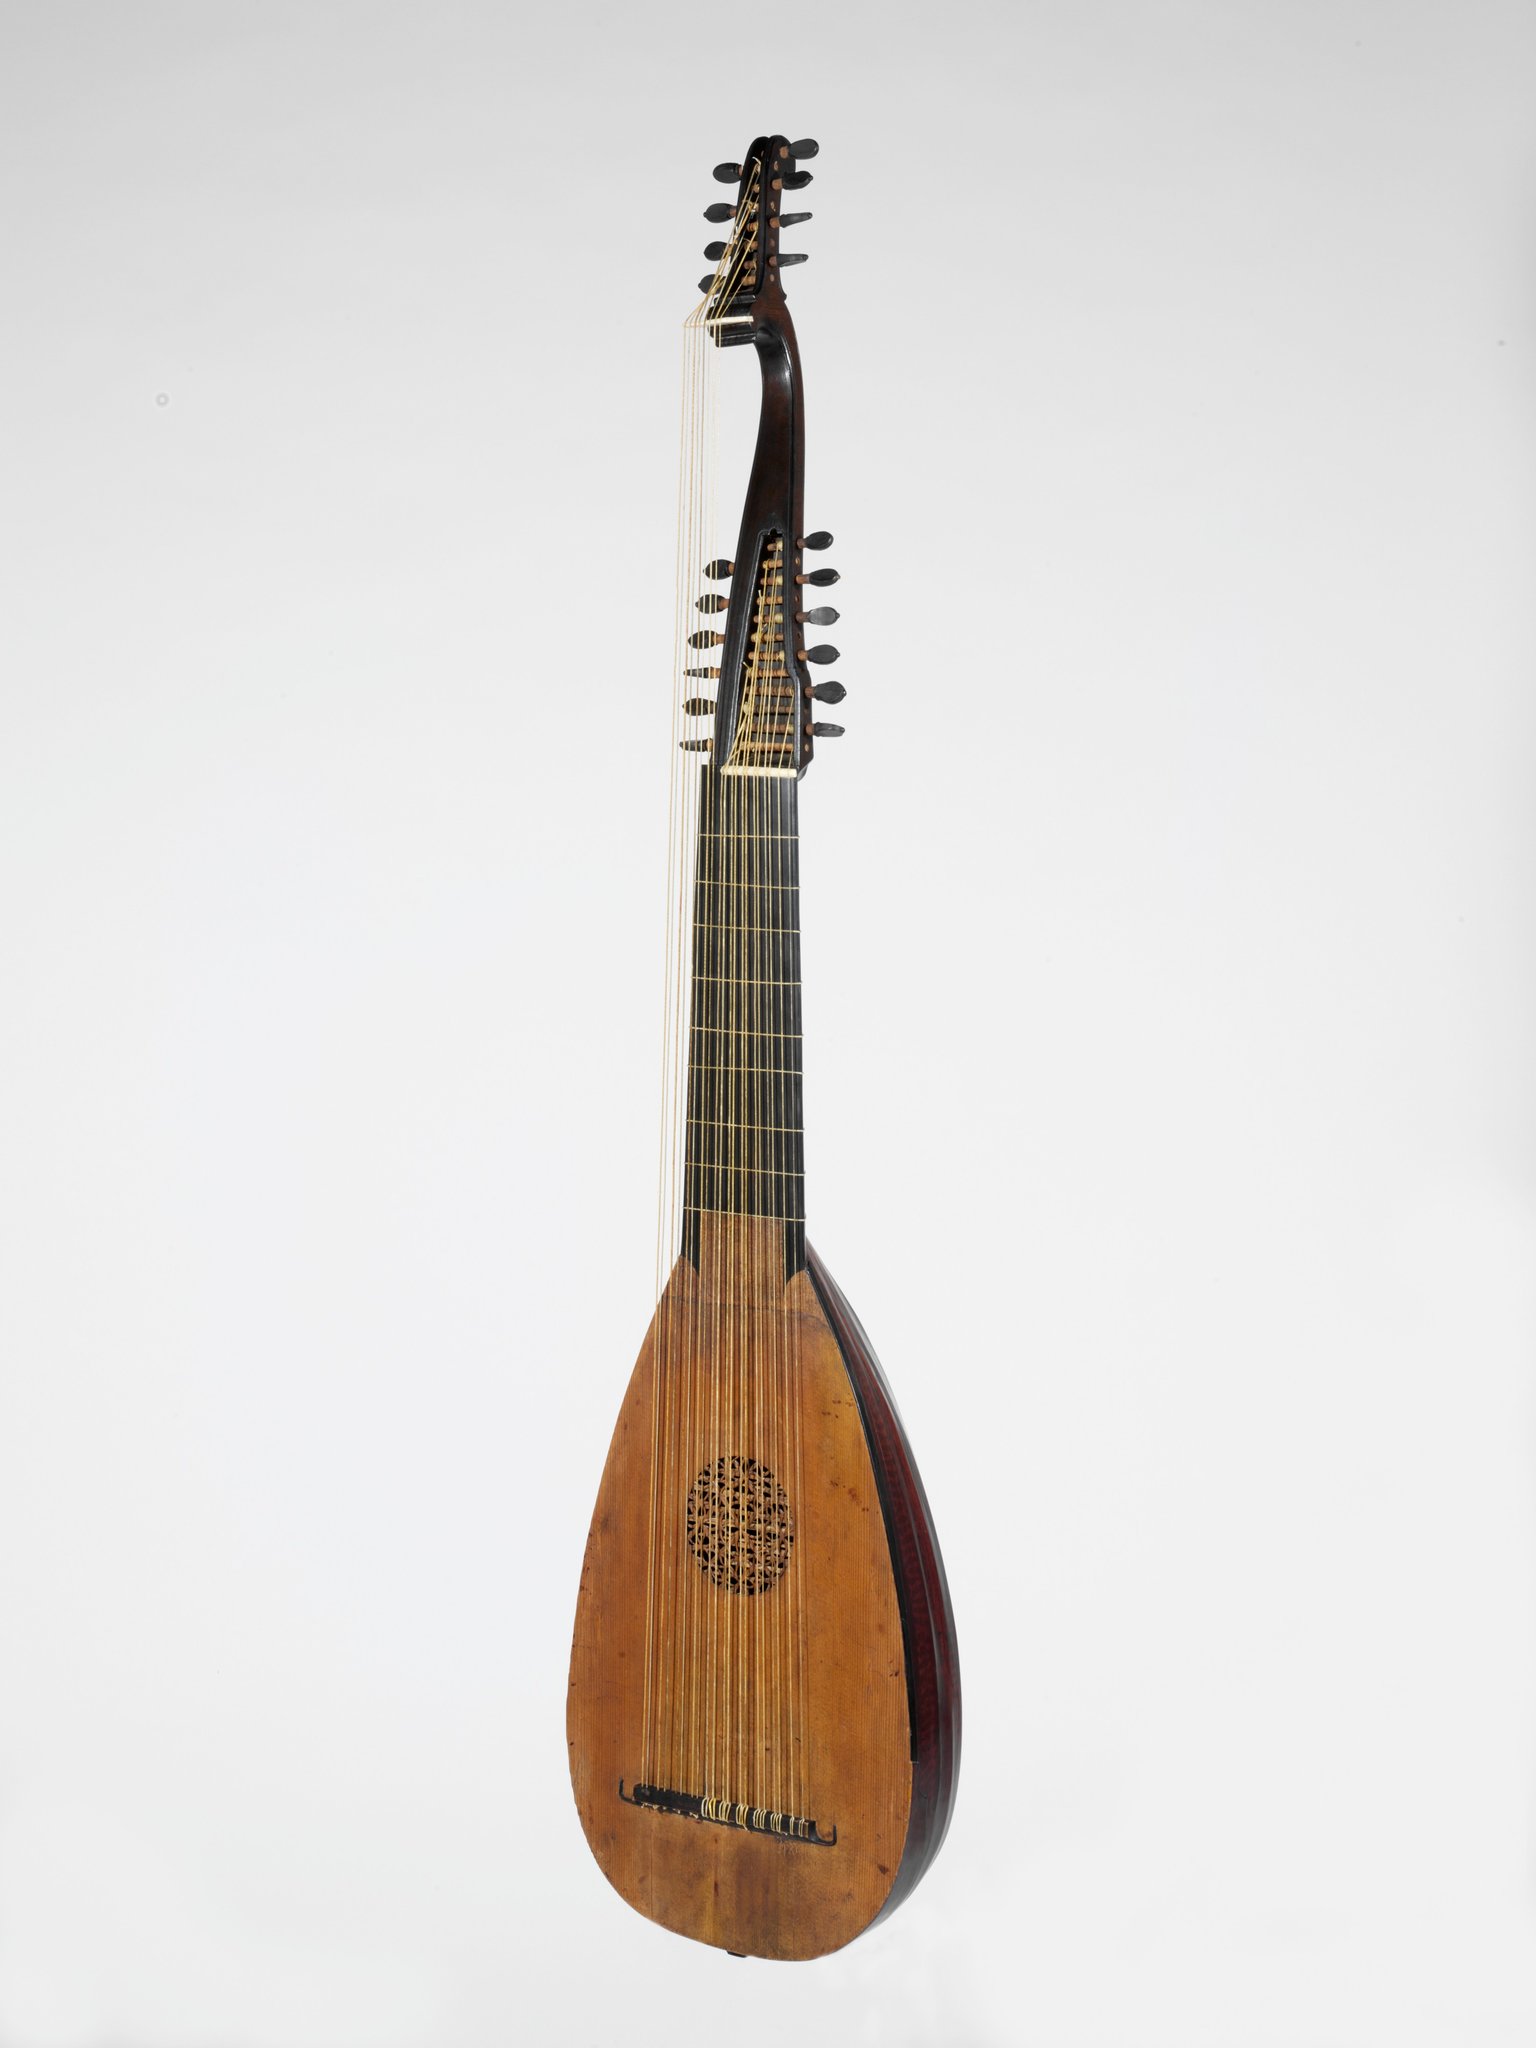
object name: lute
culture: italian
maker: pietro railich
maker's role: maker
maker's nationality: german, active italy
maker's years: 1615-1678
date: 1669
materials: wood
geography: italy